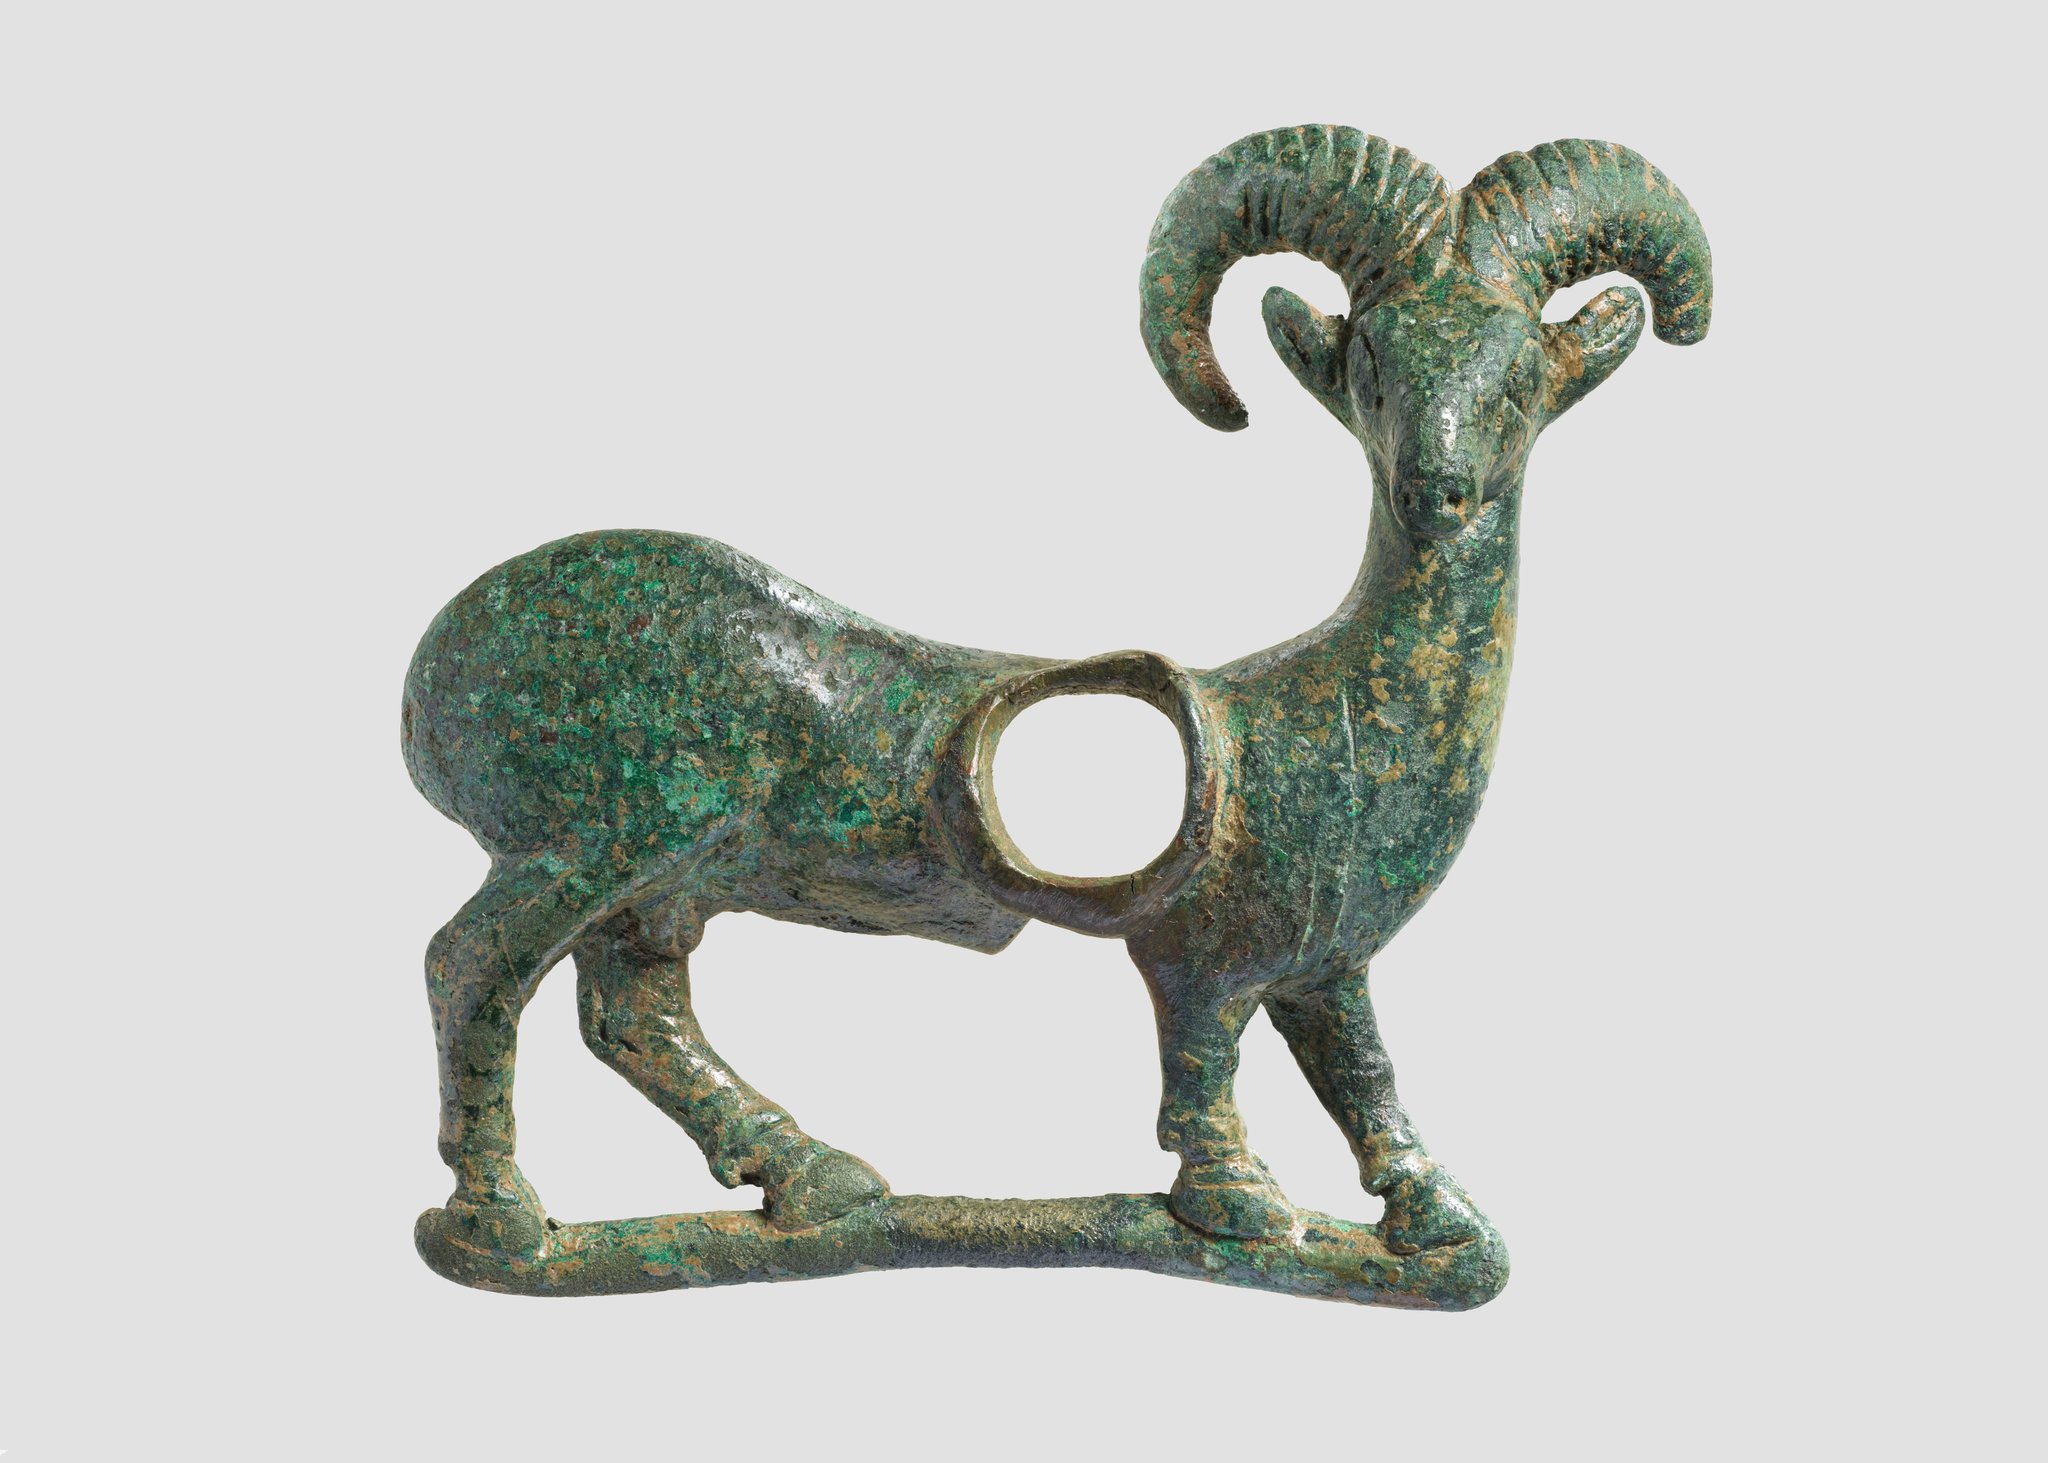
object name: horse bit cheekpiece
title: Horse bit cheekpiece in form of a mouflon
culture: iranian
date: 800-601 BCE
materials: bronze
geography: iran, probably from luristan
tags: animals